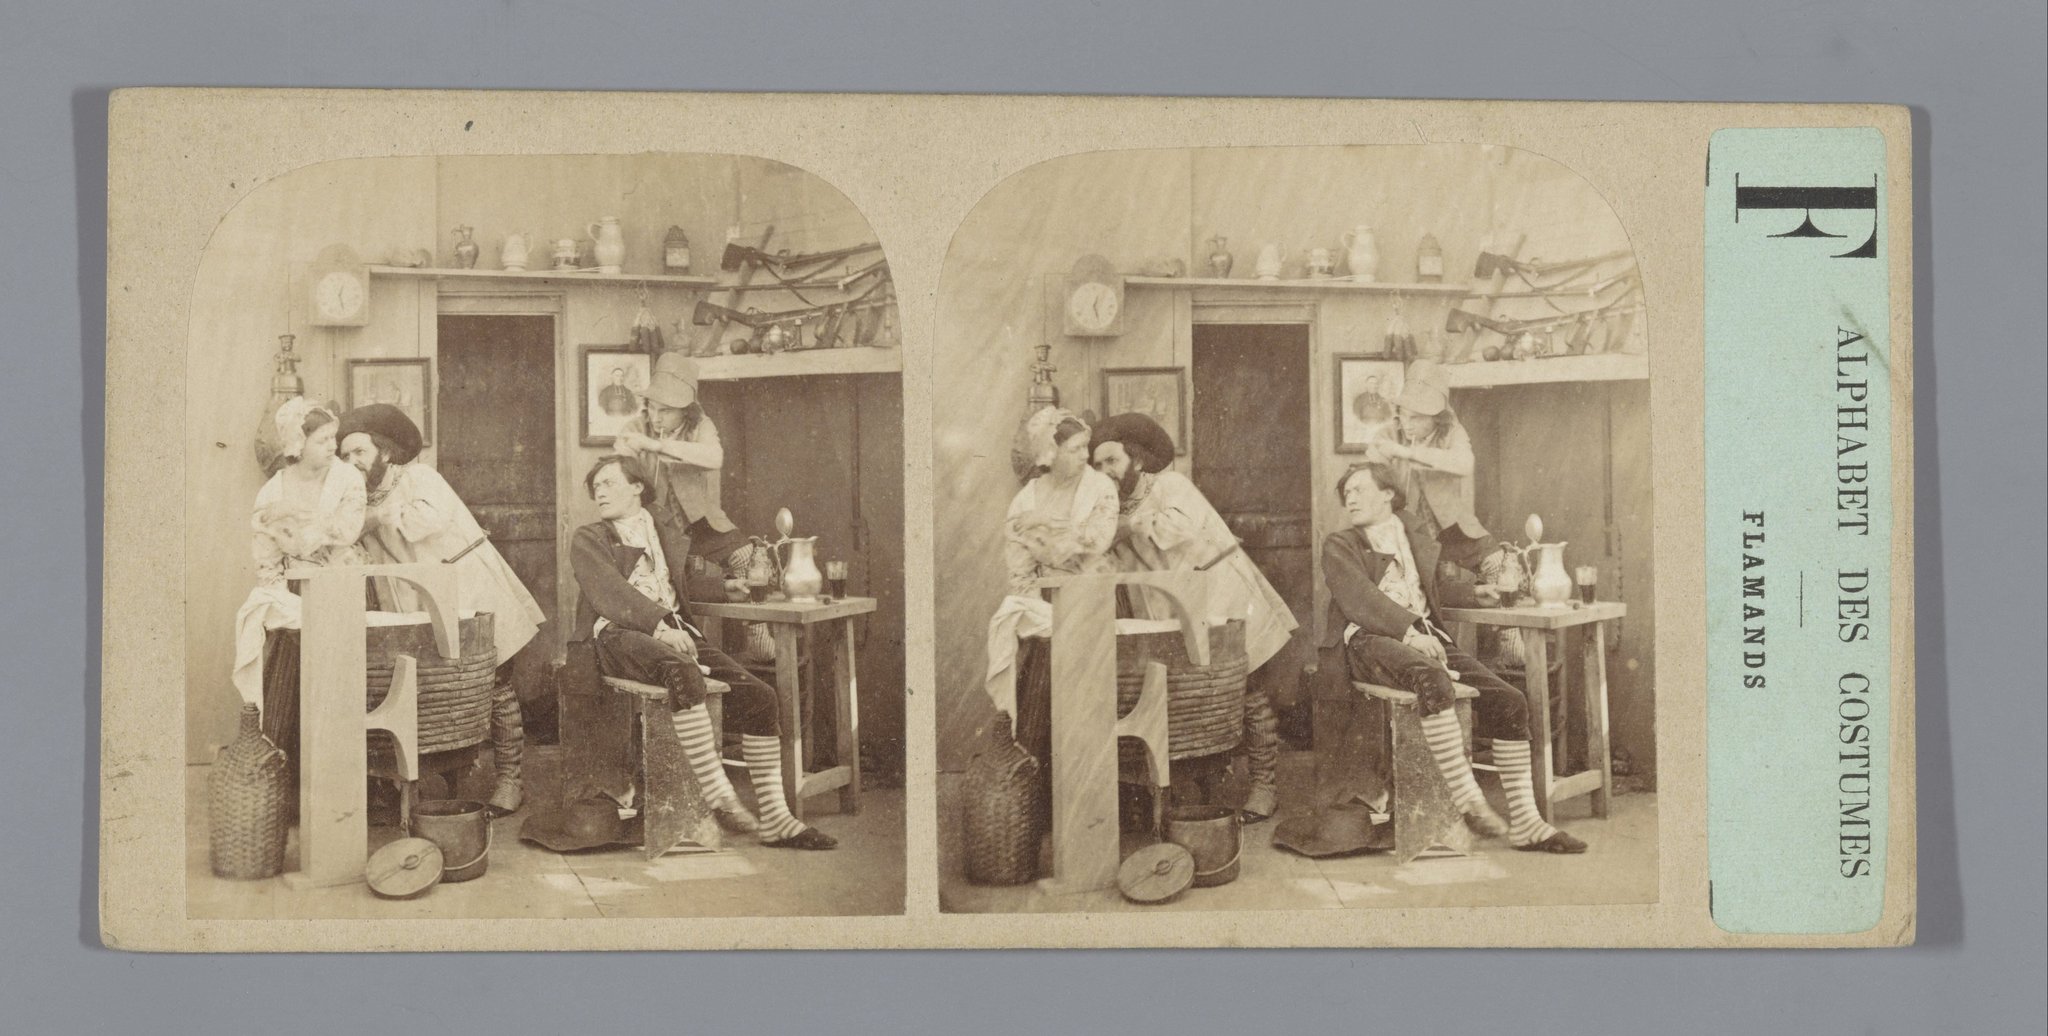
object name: stereograph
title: Theatrale voorstelling van de letter F uit het alfabet uitgebeeld door mensen in Vlaamse klederdracht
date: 1859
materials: cardboard, photographic support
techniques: albumen print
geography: europe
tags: letters, alphabet, script, folk costume, regional costume, europe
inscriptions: inscription: ‘f30’, inscription: ‘al/60’, name: ‘Feldbrugge & Co Groningen’